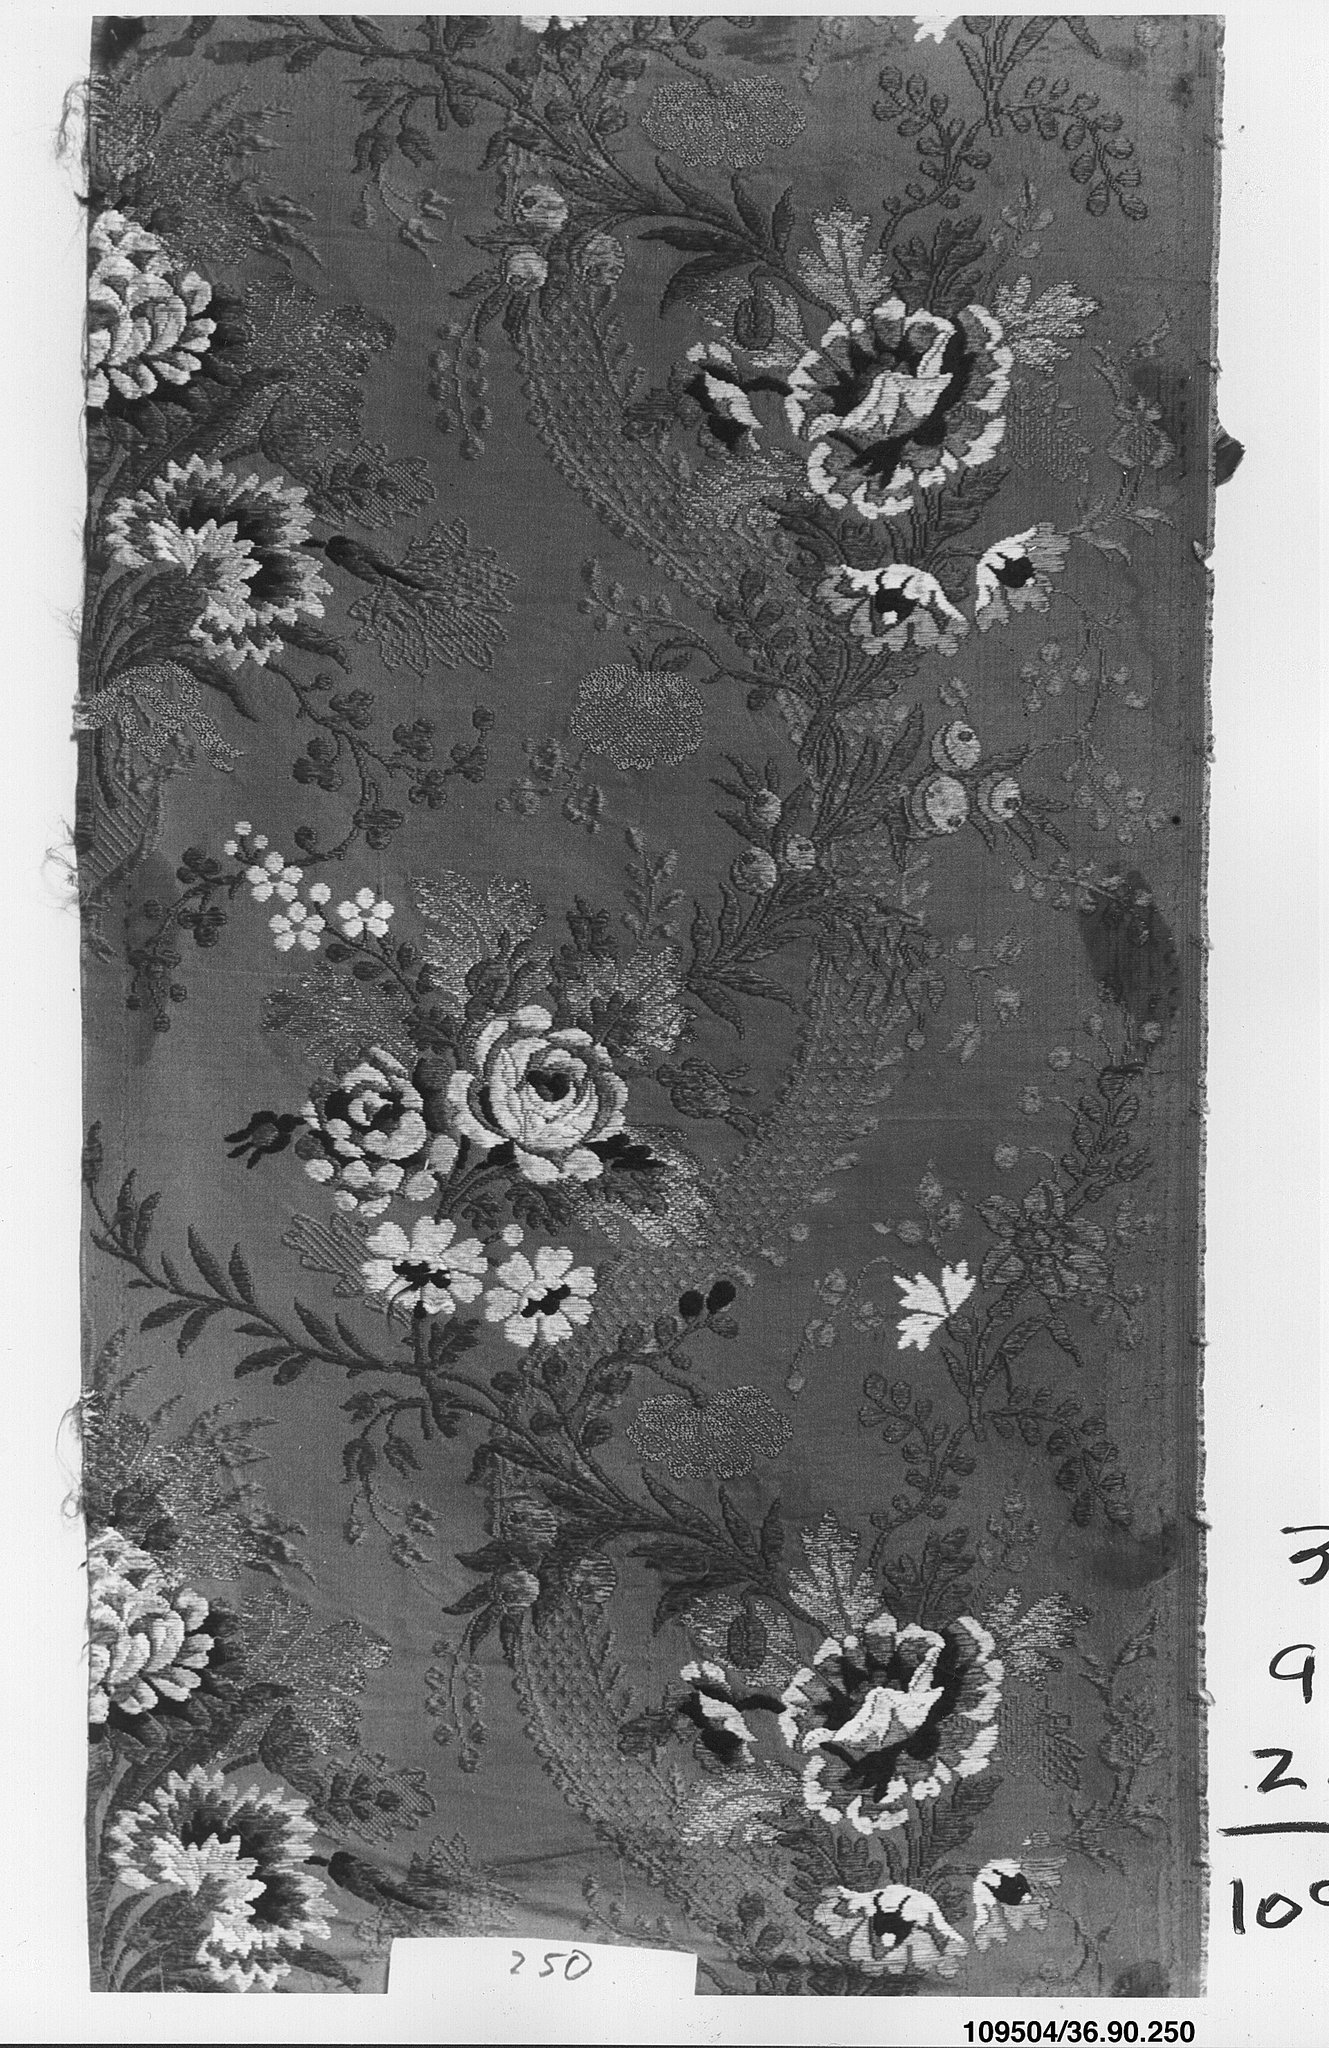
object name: piece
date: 1760-1770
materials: metal thread, silk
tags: flowers,leaves